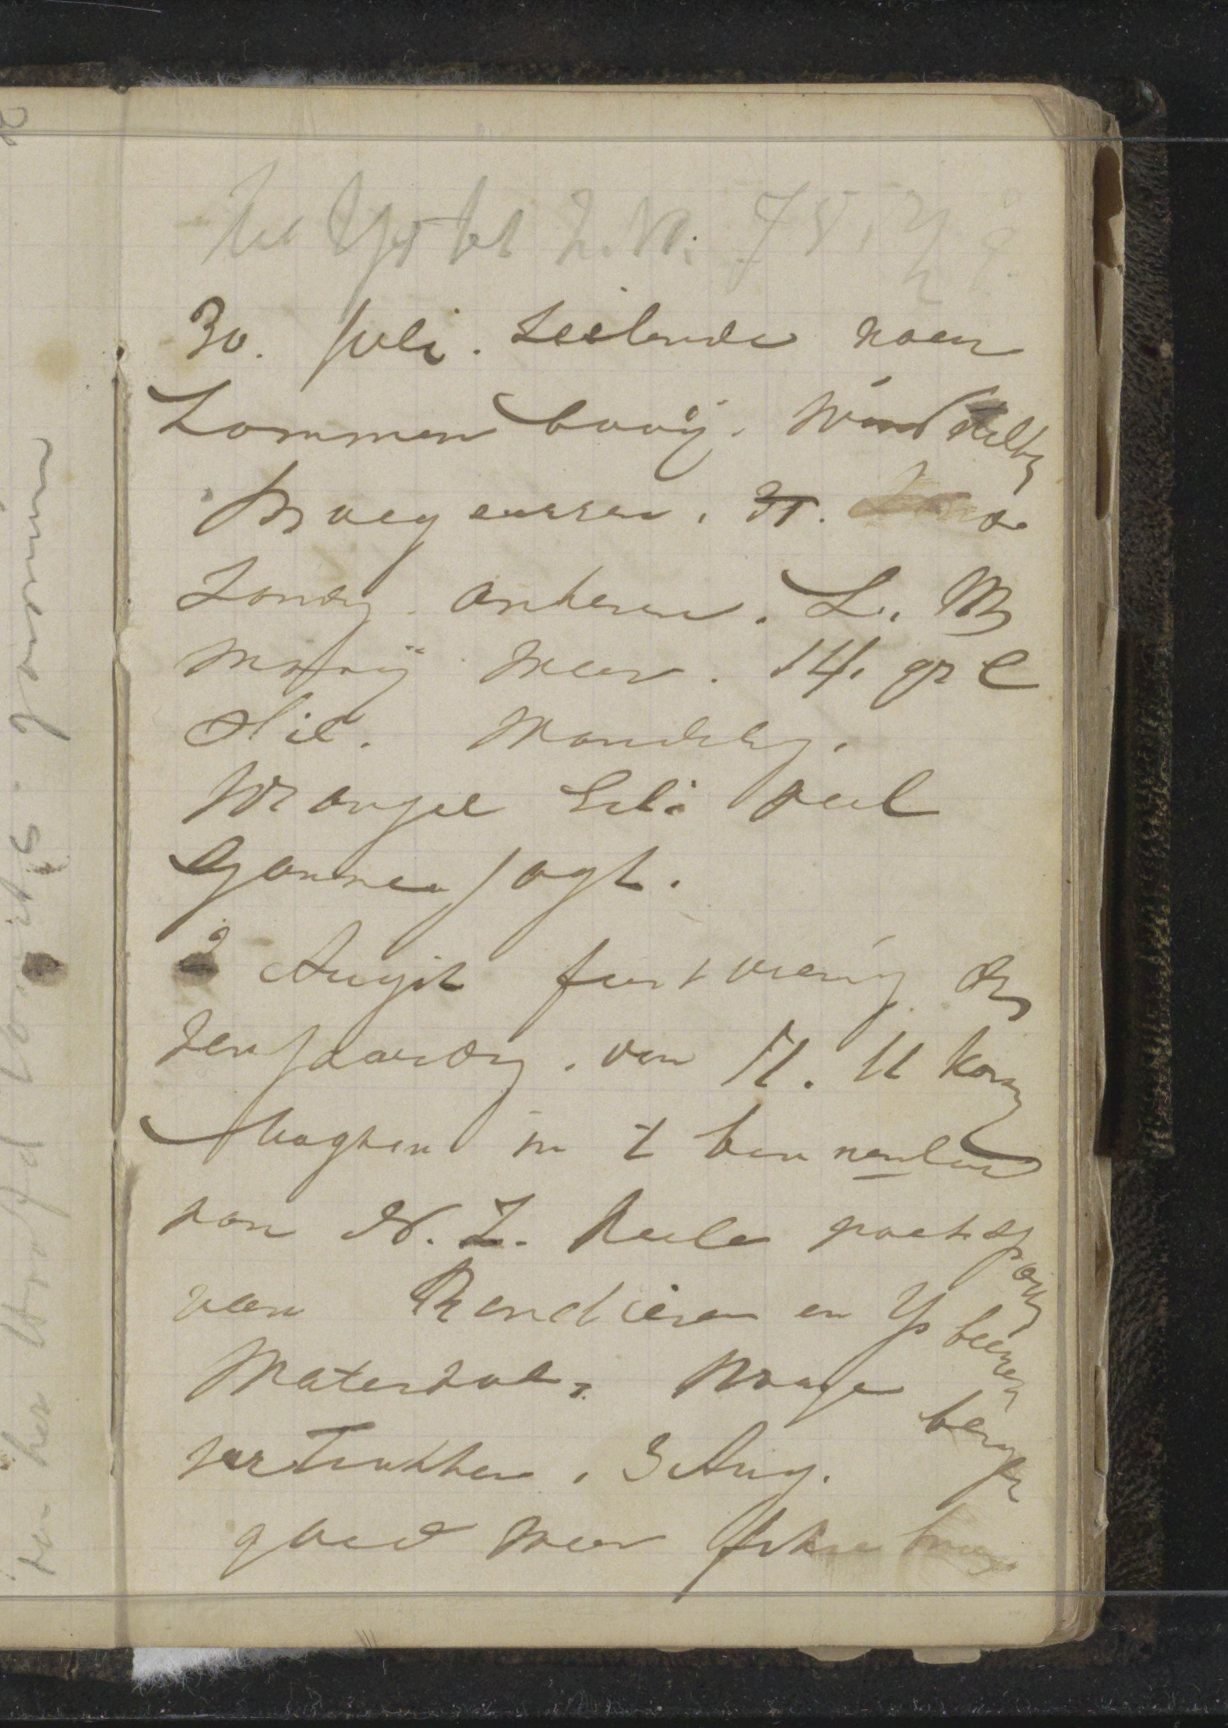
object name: sketchbook leaf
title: Reisverslag van eind juli en begin augustus 1880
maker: louis apol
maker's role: draughtsman, painter, print maker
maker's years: 1850-1936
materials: ink, pencil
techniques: pen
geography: novaya zemlya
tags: nova zembla expedities 1880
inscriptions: annotation: ‘[...] 30 juli. Zeilende naar / Lommenbaaij [...]’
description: Blad 25 recto uit een schetsboek met 110 bladen betekend tijdens de expeditie naar Nova Zembla in 1880.